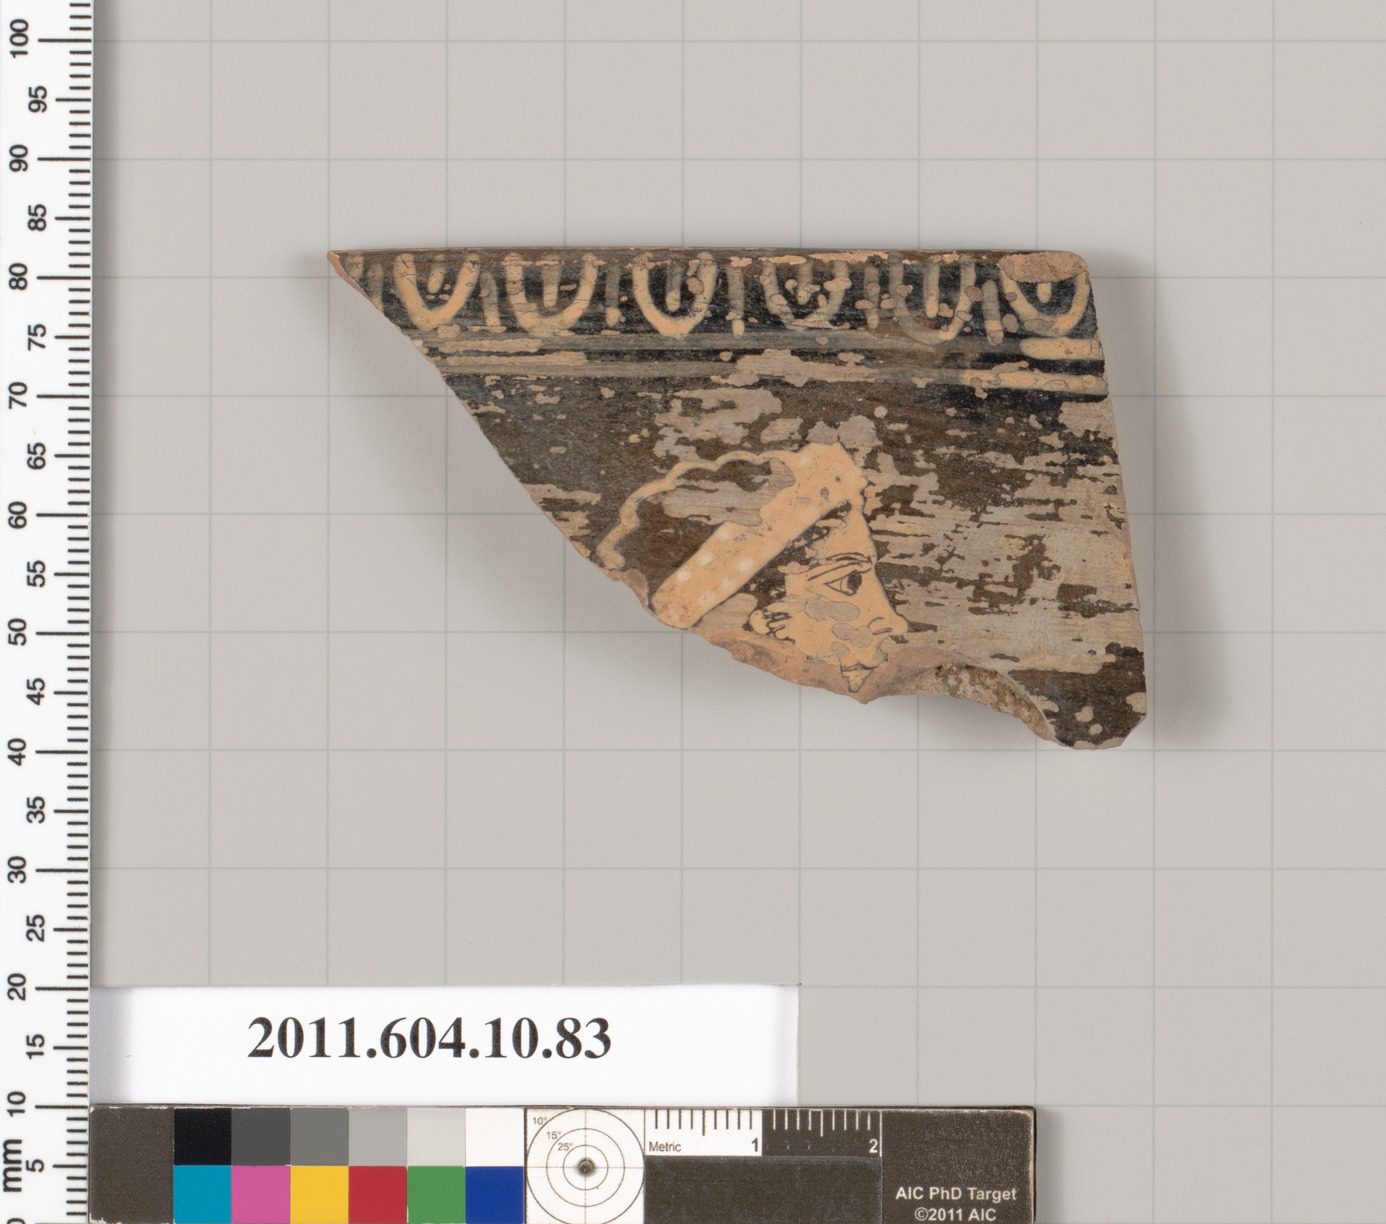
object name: skyphos fragment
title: Terracotta rim fragment of a skyphos (deep drinking cup)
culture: etruscan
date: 400-301 BCE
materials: terracotta